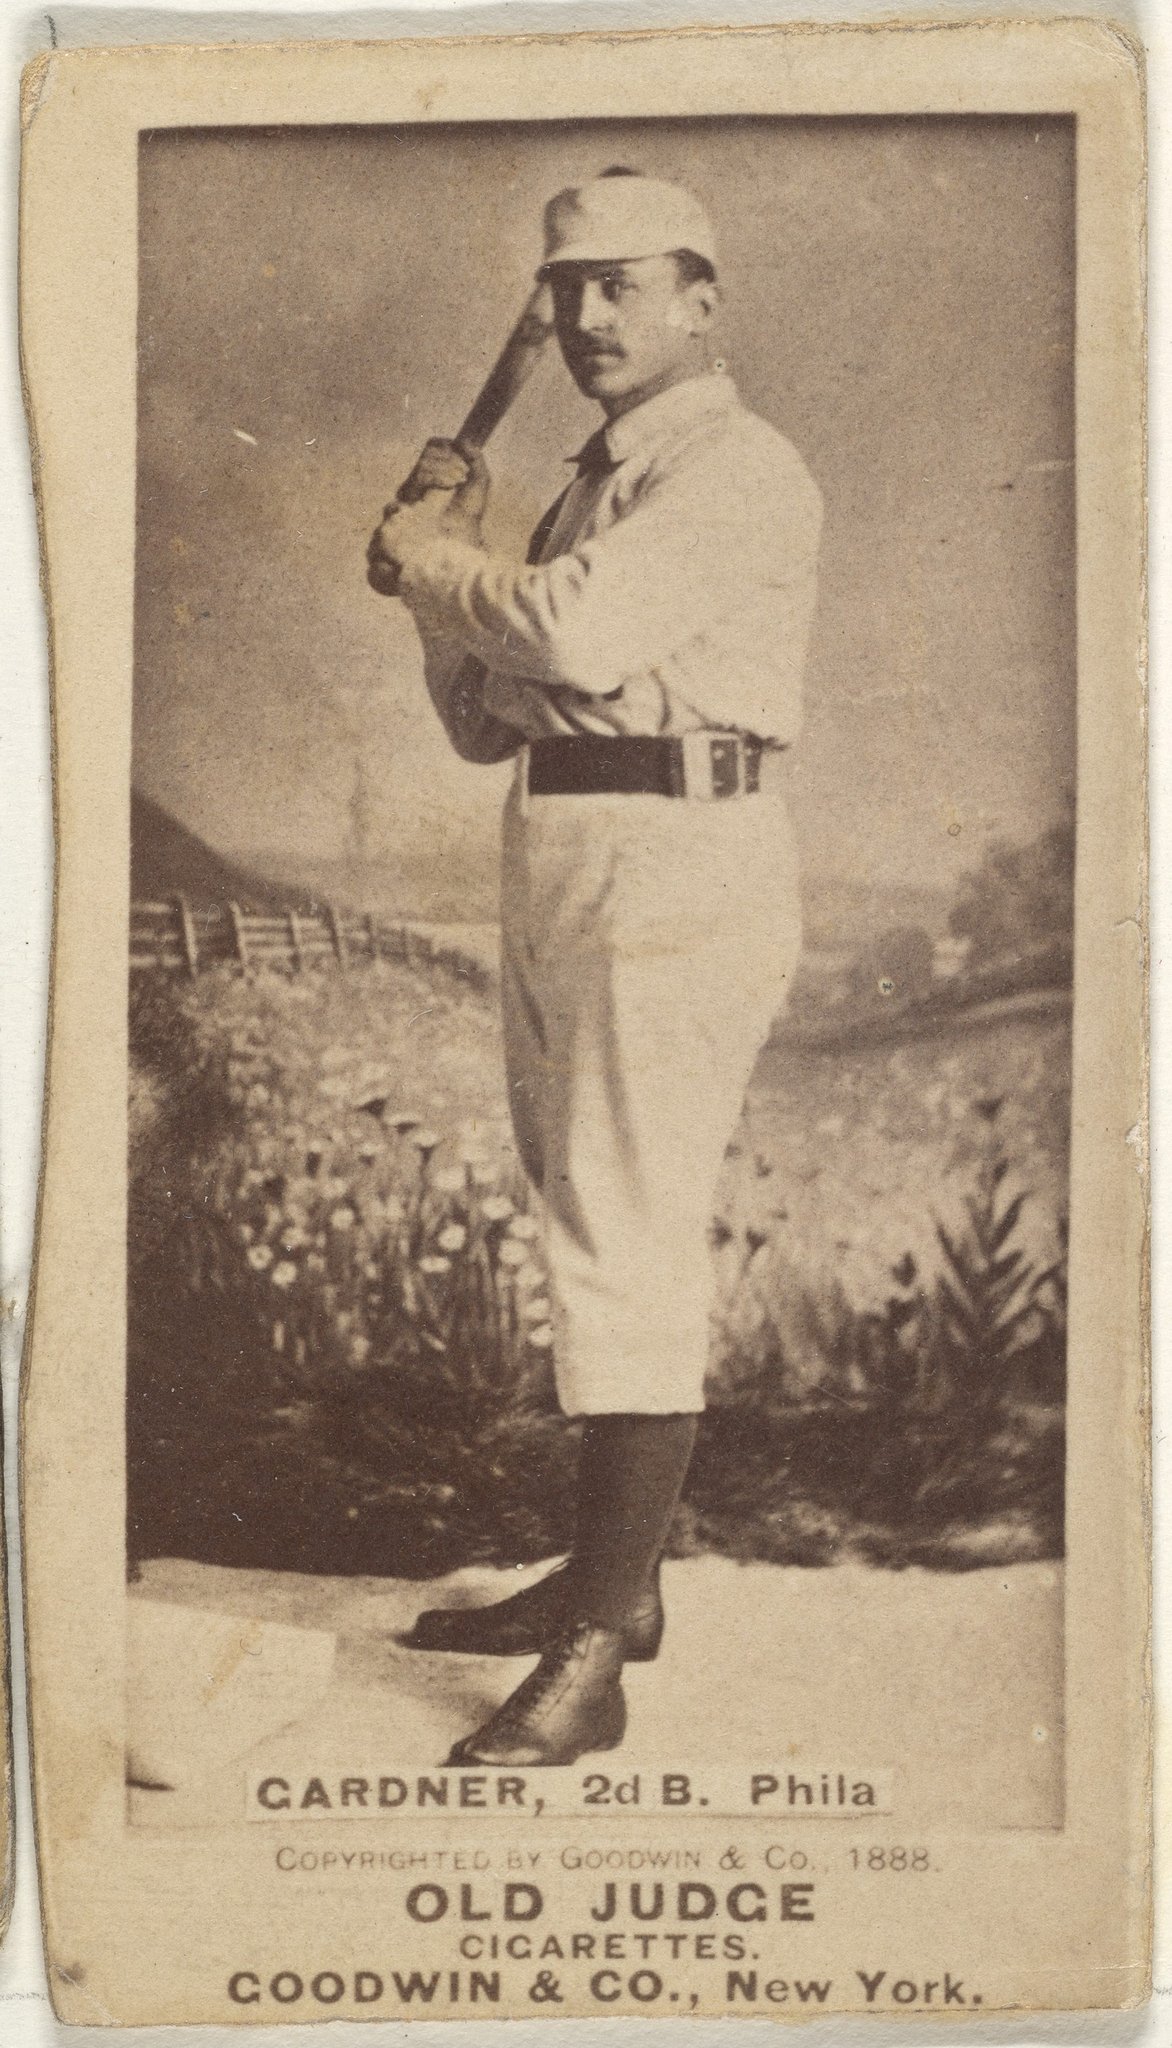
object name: baseball card, photograph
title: Franklin Washington "Gid" Gardner, 2nd Base, Philadelphia, from the Old Judge series (N172) for Old Judge Cigarettes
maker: goodwin & company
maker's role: publisher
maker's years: 1850-1950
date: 1888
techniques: albumen silver print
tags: men,portraits,baseball,athletes